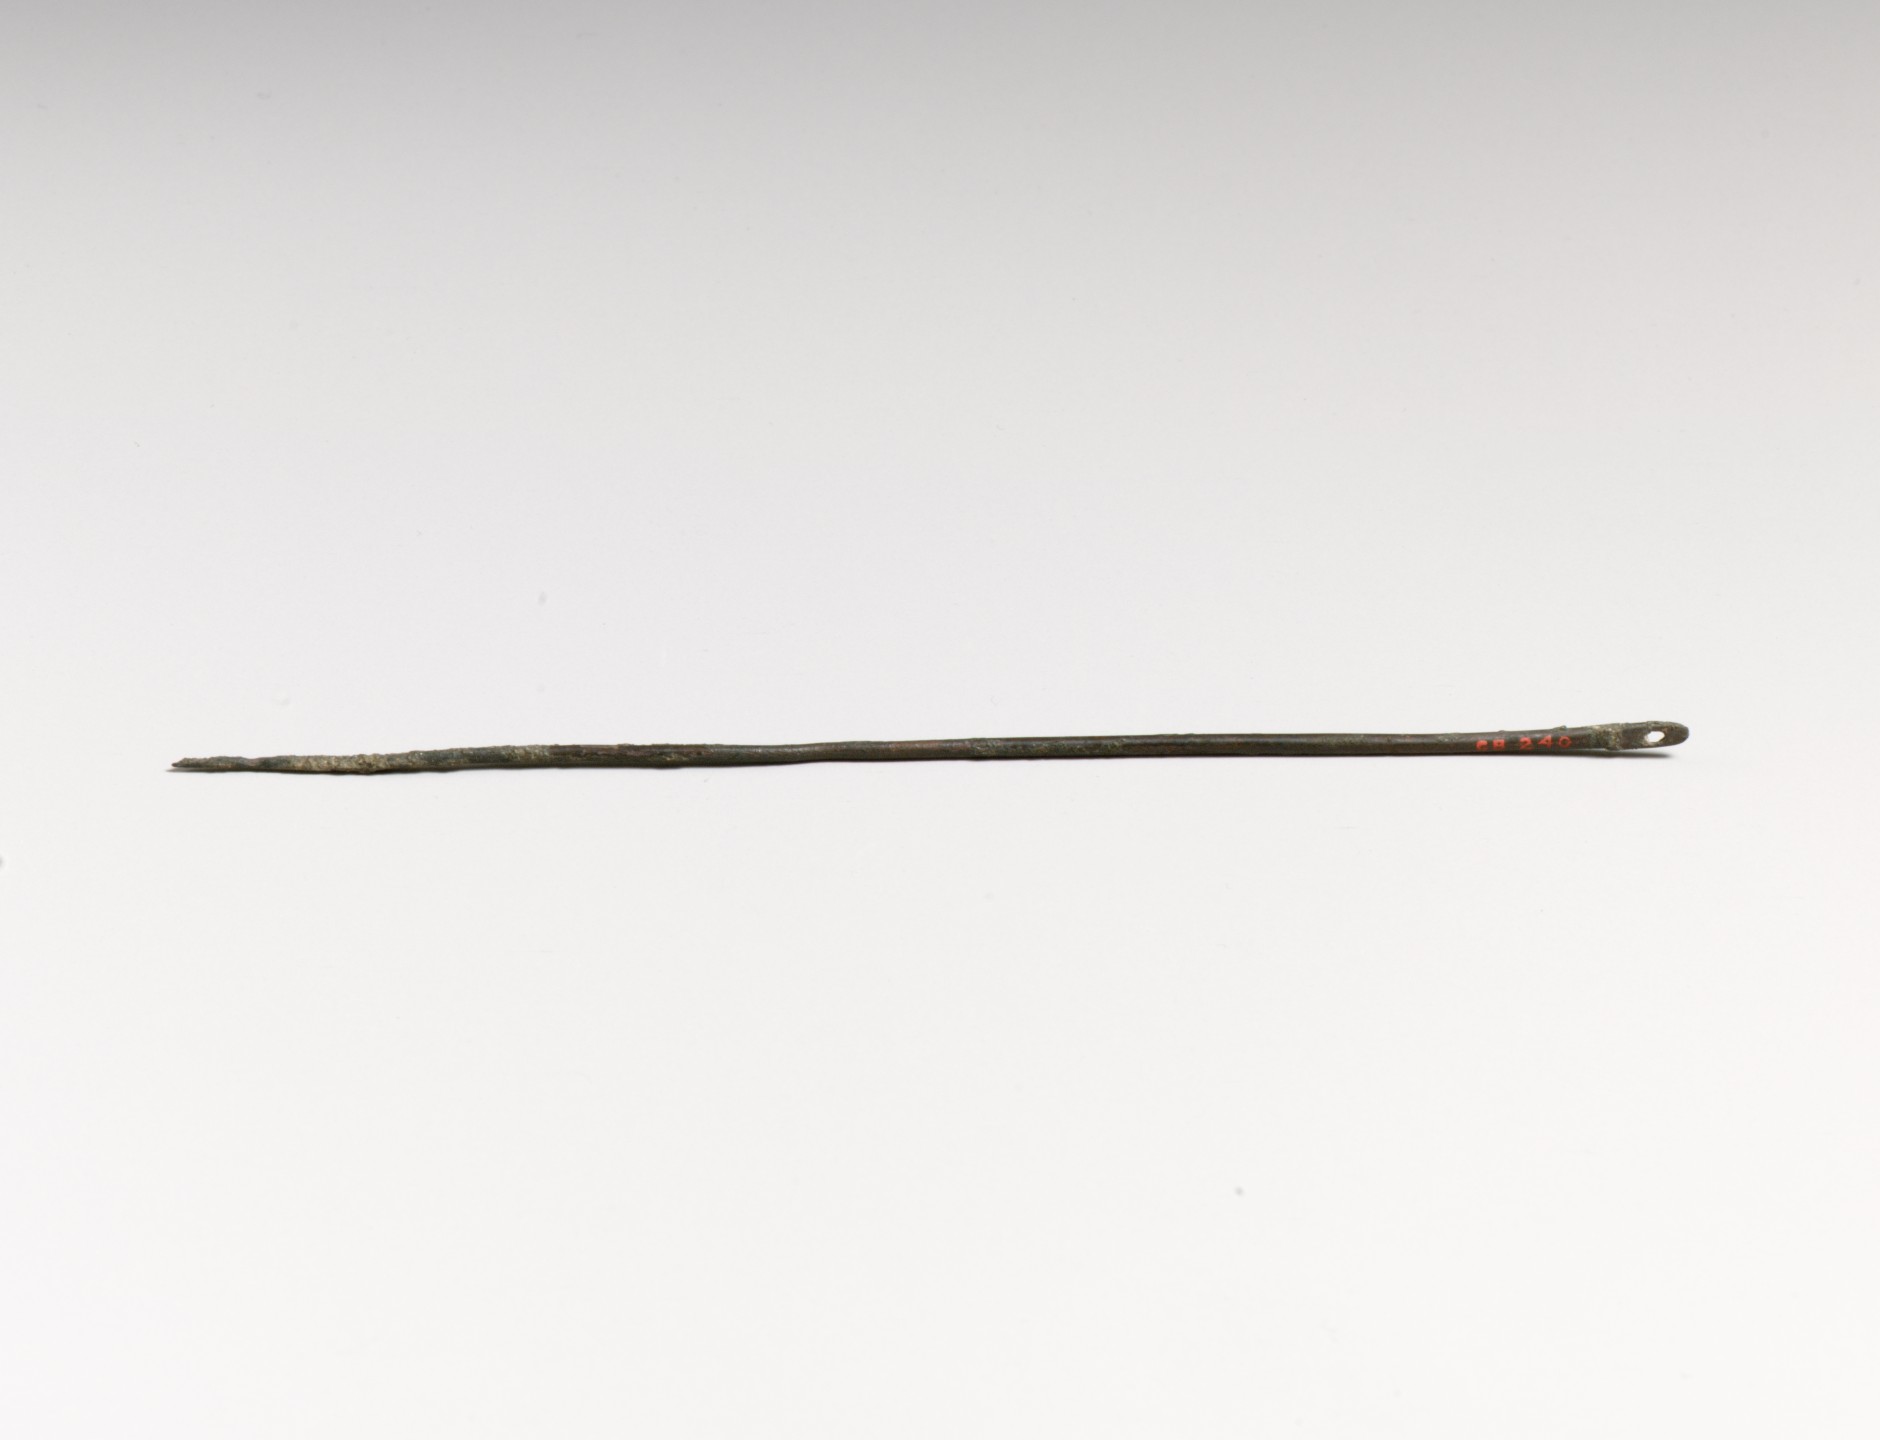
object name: needle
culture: cypriot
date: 3900 BCE-100 CE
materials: bronze